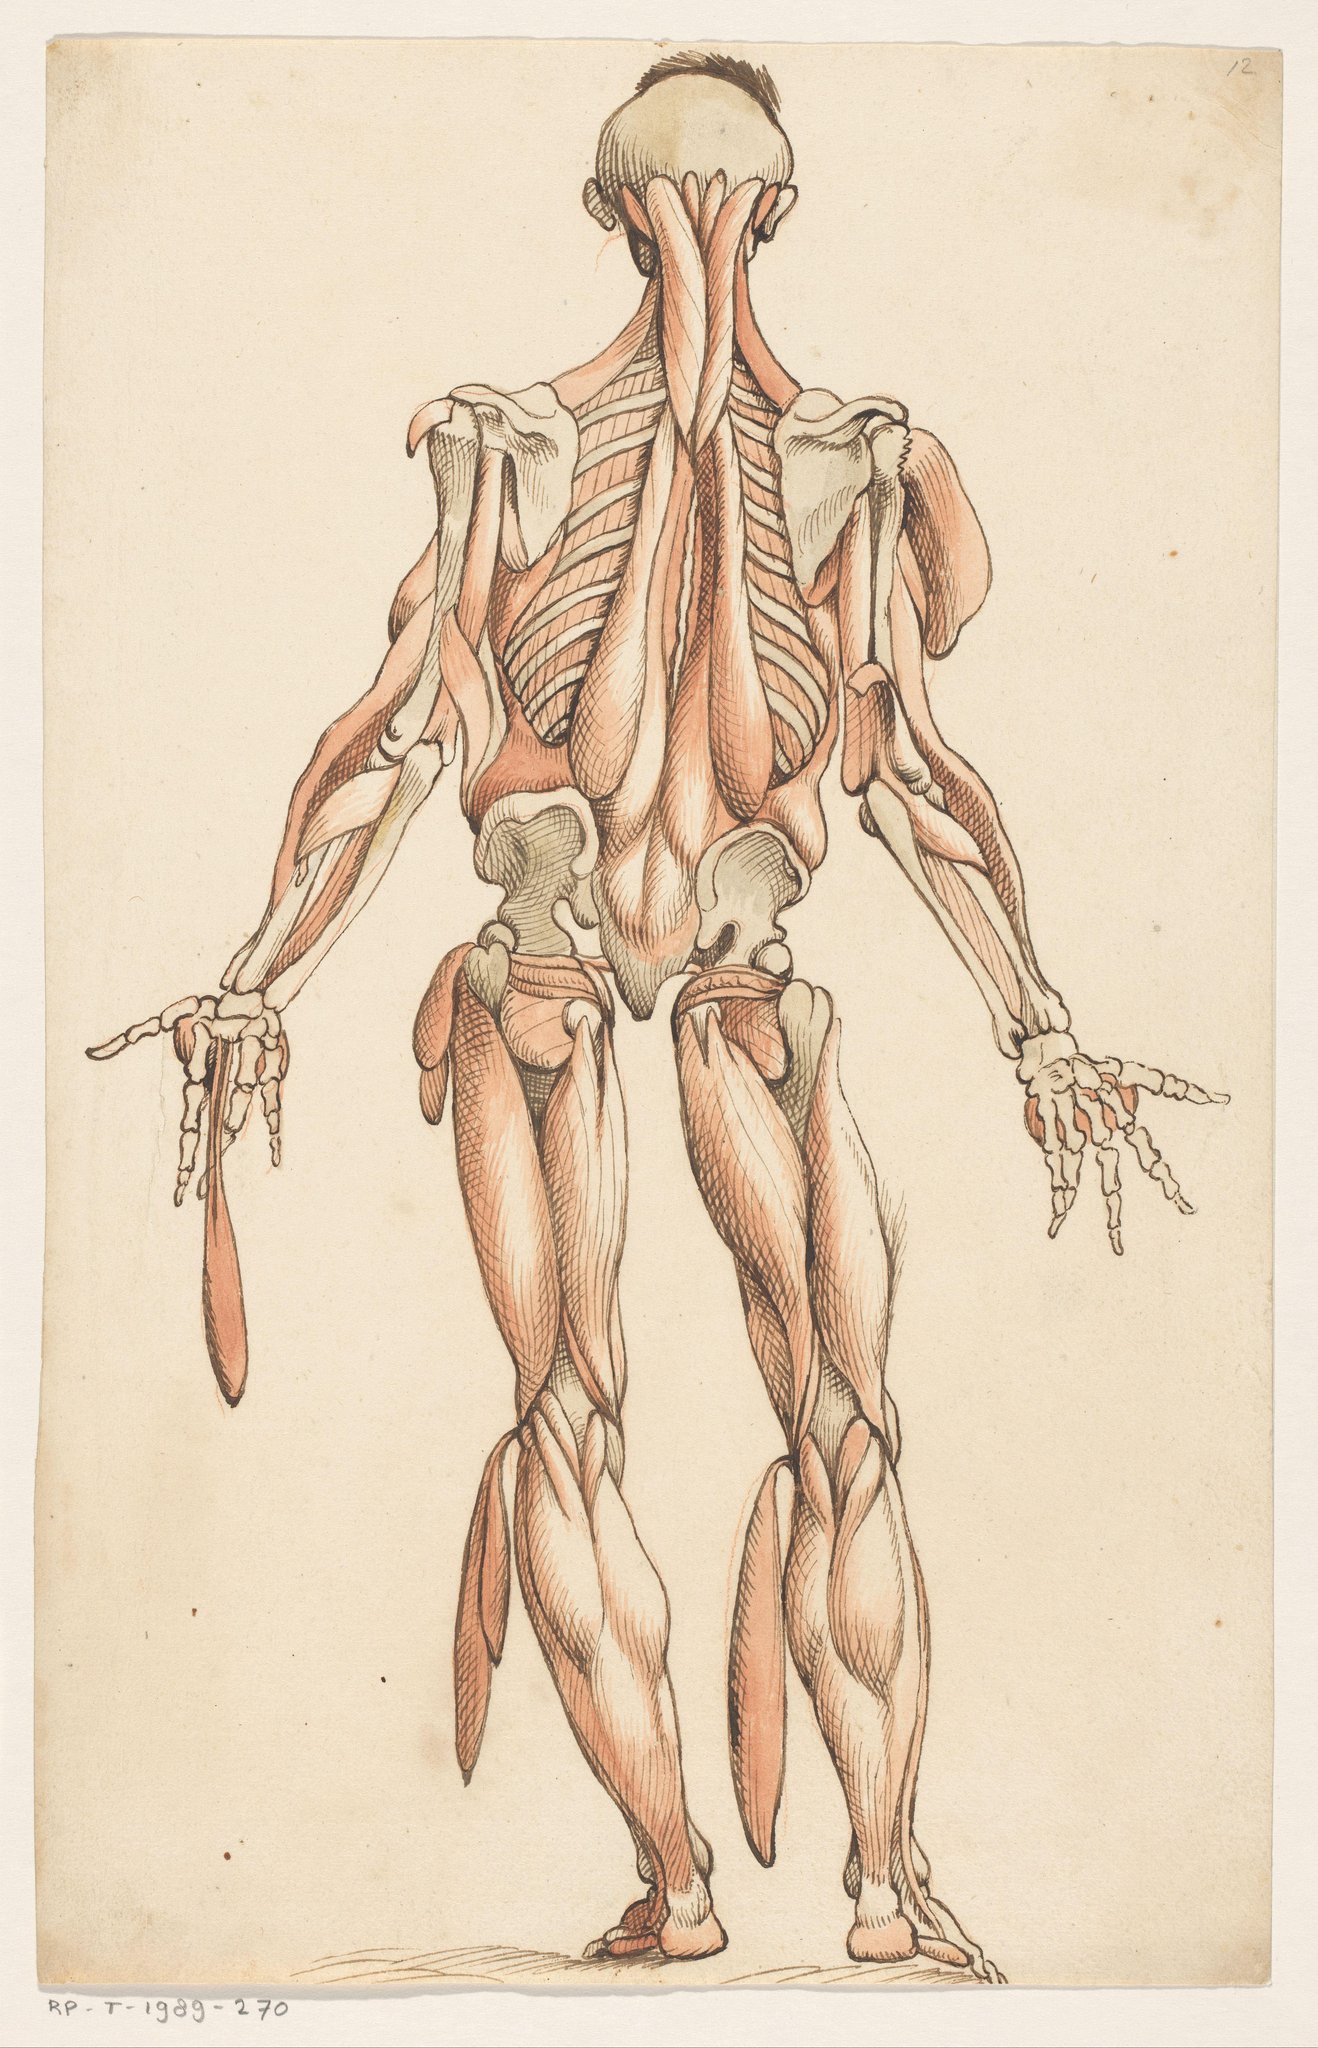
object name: drawing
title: Spieren en skelet van het menselijk lichaam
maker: Anonymous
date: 1600-1649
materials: ink, paper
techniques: brush, pen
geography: low countries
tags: muscles, (human) skeleton, anatomical model of the muscles, muscle-man, 'écorché'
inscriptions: collector's mark: Lugt 2228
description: De tekening komt sterk overeen met een prent in: Gracht, Jacob van der. Anatomie der wtterlicke deelen van het menschelick lichaem (...). Den Haag: Jacob van der Gracht, 1634. De tekening is echter gespiegeld en zou mogelijk als voorbeeld voor de prent kunnen hebben gediend. De houding waarin het lichaam is afgebeeld gaat terug tot: Vesalius, Andreas. De humani corporis fabrica libri septem (...). Bazel: Johannes Oporinus, 1543. Tekening zit in een omslag met meerdere anatomische tekeningen, genummerd RP-T-1989-256 en RP-T-1989-258 t/m RP-T-1989-289.